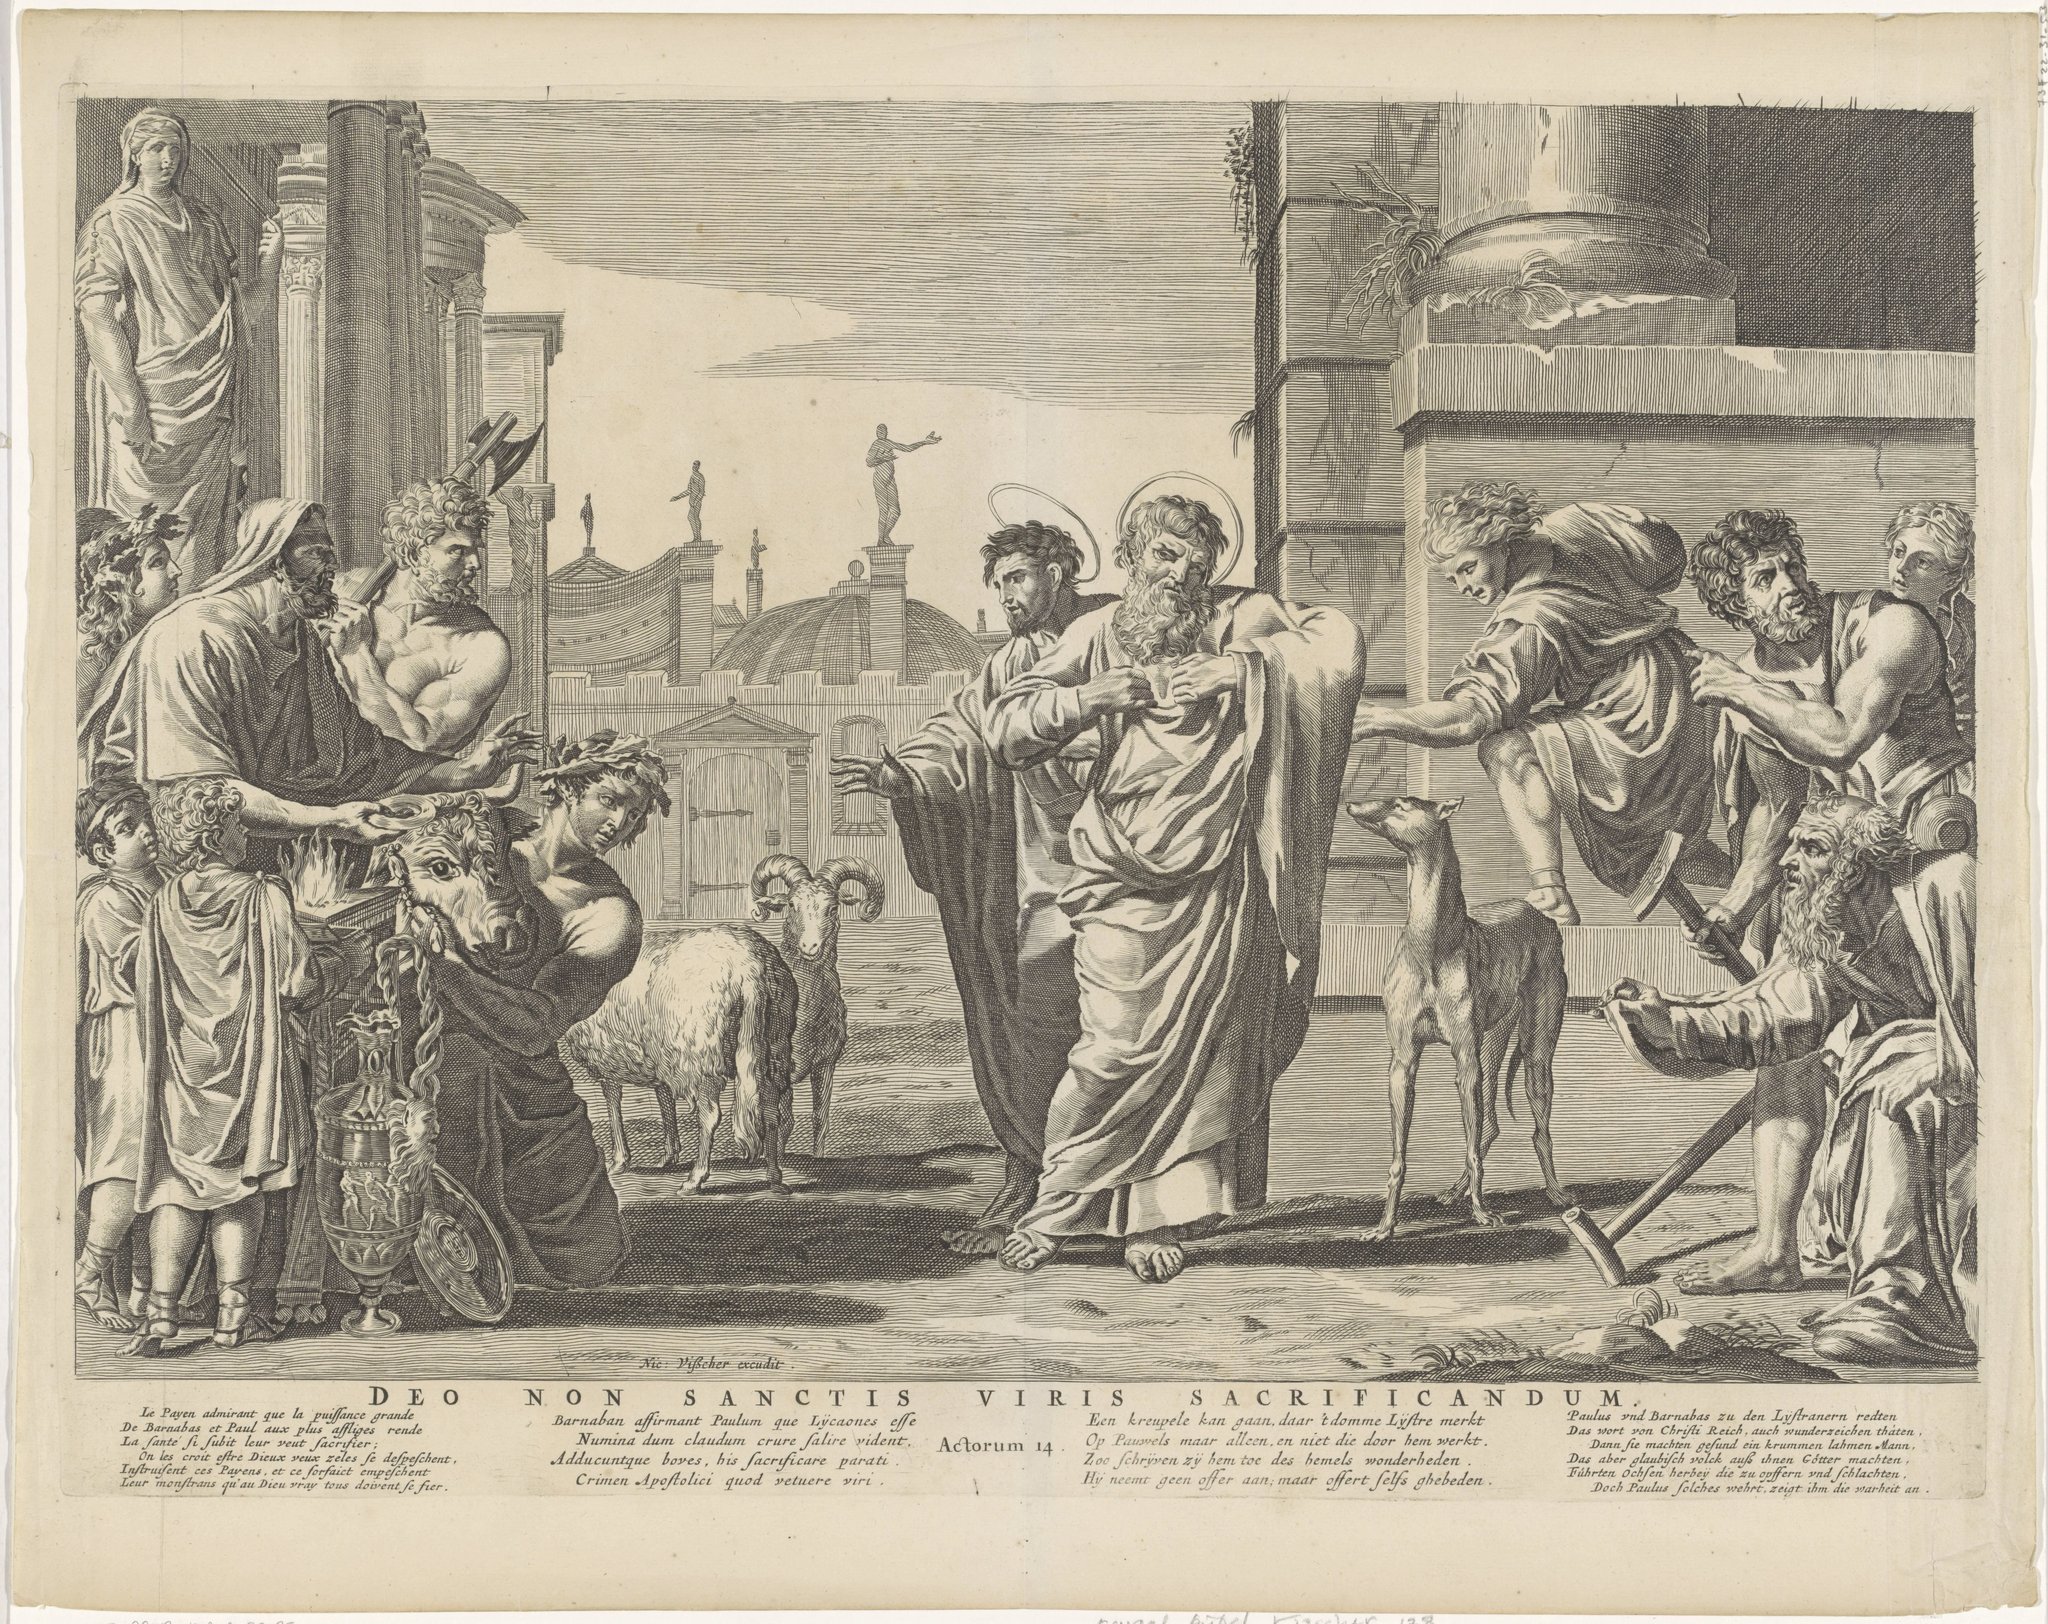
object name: print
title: Deo non sanctis viris sacrificandum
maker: Anonymous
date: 1652-1702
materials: paper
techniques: engraving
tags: paul and barnabas tear their clothes, and try to prevent the sacrifice, preparation of the sacrificial celebration with oxen and garlands in front of the temple of jupiter ~ paul and barnabas at lystra, paul and barnabas heal the feet of a man; the people of lystra think they are mercury and jupiter, paul and barnabas at lystra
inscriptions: collector's mark: Lugt 2228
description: De Amsterdamse uitgever Claes Jansz. Visscher (II) produceerde vanaf de jaren ’30 van de zeventiende eeuw grote Bijbelse prenten op zogenaamd royaal-formaat papier (ca. 480 x 580 mm). Na zijn dood in 1652 zette zijn zoon Nicolaes Visscher (I) het bedrijf voort en zo ook de uitgave van Royaalbijbelprenten. Toen Nicolaes in 1679 overleed nam zijn zoon Nicolaes Visscher (II) het bedrijf over en gaf kort hierna, omstreeks 1680, een fondslijst uit. Hierin worden 130 prenten met Bijbelse voorstellingen op royaalpapier beschreven (zie documentatie J. van der Waals). Complete prentbijbels op royaal-formaat werden door vader en zoon Nicolaes Visscher uitgegeven onder de titel Historiae Sacrae Veteris et Novi Testamenti. De bladen werden echter ook los verkocht en konden worden gecombineerd met Royaalbijbel-prenten van andere uitgevers. Verschillende Amsterdamse uitgevers brachten namelijk ook bijbelprenten op royaal-formaat uit, onder wie Clement de Jonghe en Cornelis Danckerts. De door de firma Visscher uitgegeven prenten zijn veelal vervaardigd door anonieme prentmakers naar voorbeeld van verschillende zestiende- en zeventiende-eeuwse Bijbelse prenten en prentreeksen. Veelal moesten de composities worden aangepast aan het grotere en langgerekte royaal-formaat. Daarnaast zijn er ook grote bladen van bekende prentmakers zoals Jan van Londerseel, Pieter Nolpe, Jacques de Gheyn (II) en Jan Harmensz. Muller opgenomen in de categorie ‘Bybelsche Figuren, op Royaal-bladen’ in de fondslijst van Visscher. Prent mogelijk gebruikt in: Historiae Sacrae Veteris et Novi Testamenti (Royaalbijbel). Amsterdam: Nicolaes Visscher (I) en (II), [1652-1702]. In de fondslijst van Nicolaes Visscher II (ca. 1680) is het onderwerp van deze prent onder de titel 'Bybelsche Figuren, op Royaal-bladen. bestaande uyt de volgende historien.' als volgt genummerd: 128.